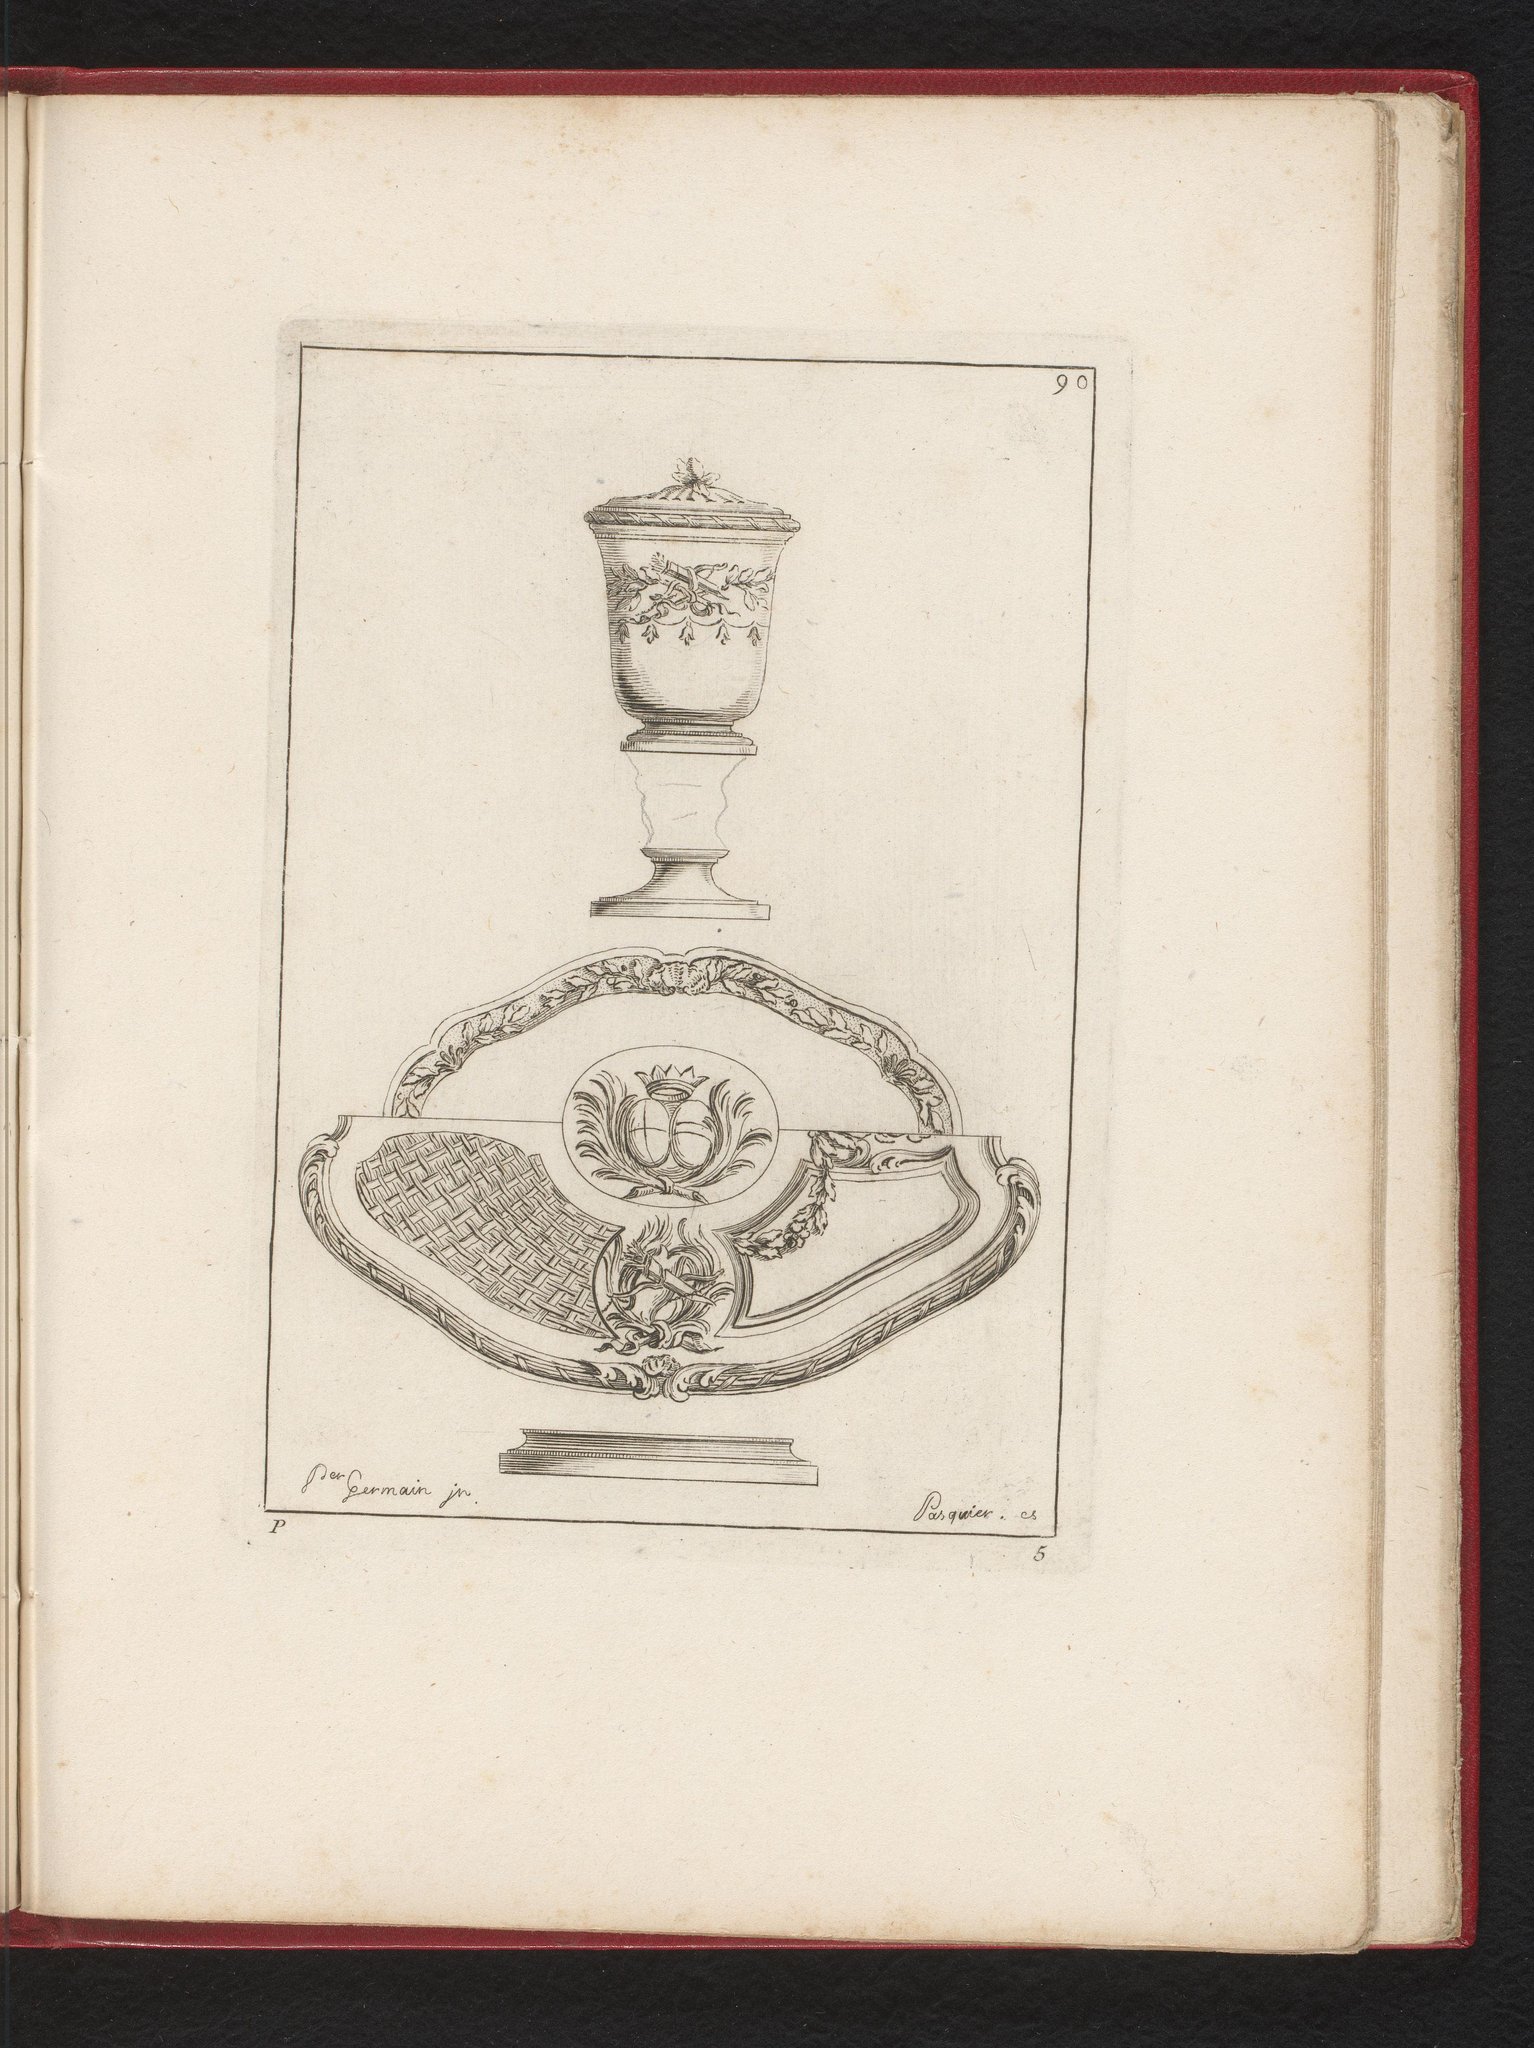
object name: album leaf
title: Elements d'orfevrerie divisés en deux parties de cinquante feuilles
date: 1748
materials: paper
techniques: etching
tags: serving-dish, platter, coffee-pot, jeweller, goldsmith, silversmith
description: Een aantal van de objecten in deze reeks heeft een eigen ondertitel, die verwijst naar genummerde 'cahiers' (afleveringen) waarin de prenten werden uitgegeven. Het is onduidelijk welke objecten recies bij welke aflevering horen. Daarom is die ondertitel enkel verwerkt bij de prent waarop die voorkomt.